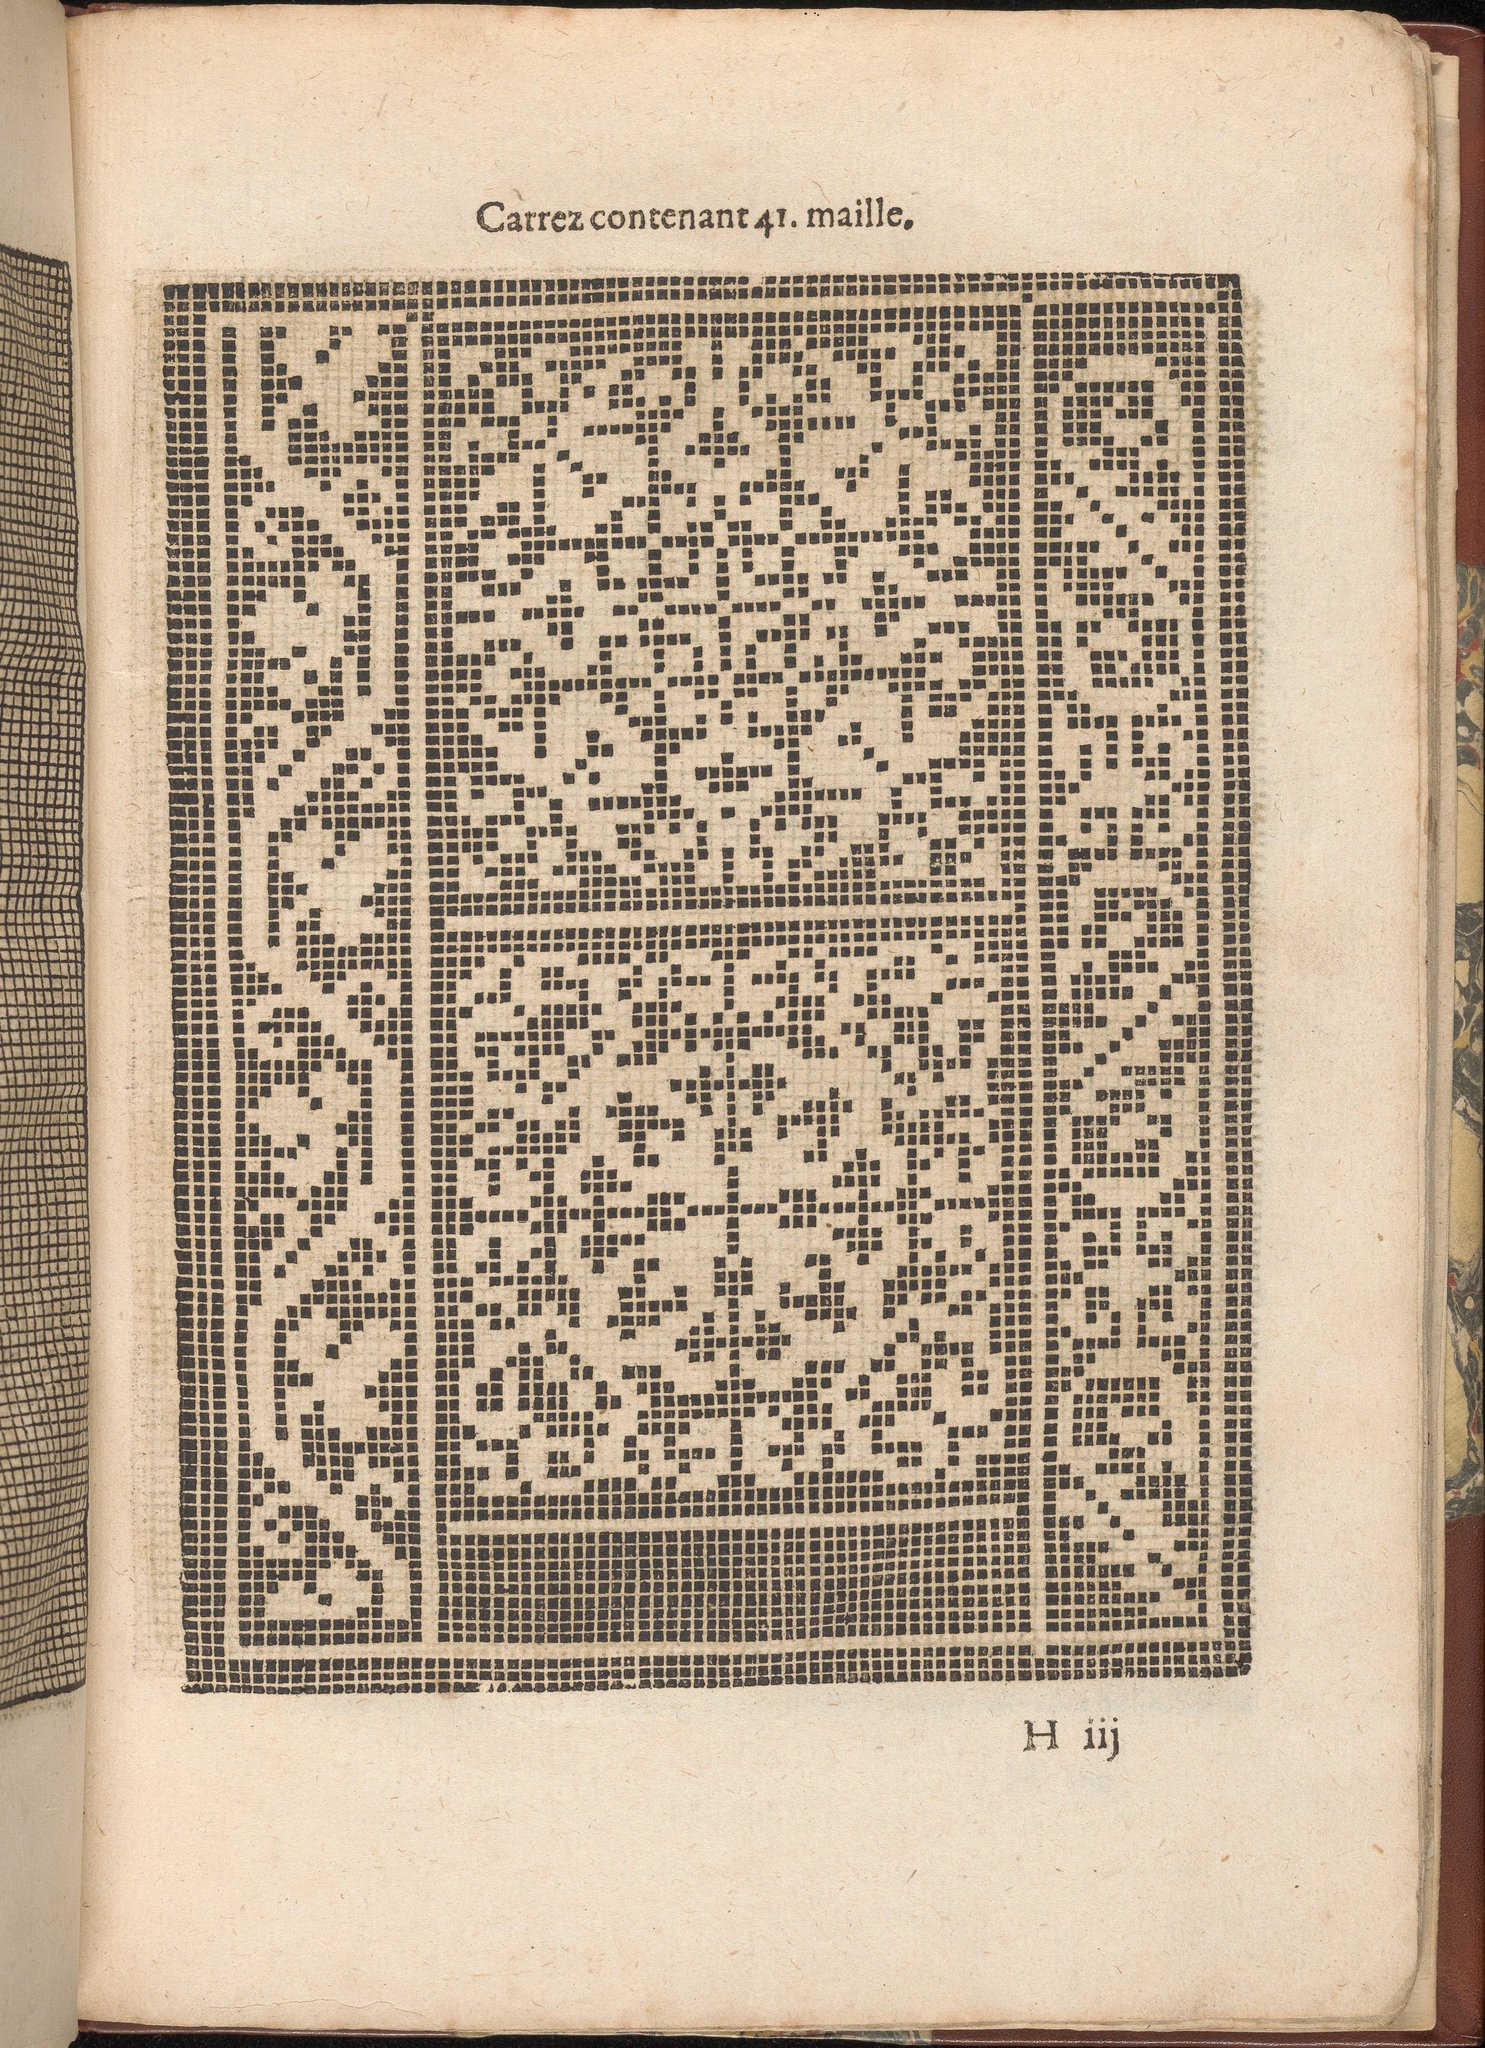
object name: book print ornament architecture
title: Les Secondes Oeuvres, et Subtiles Inventions De Lingerie du Seigneur Federic de Vinciolo Venitien, page 31 (recto)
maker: federico de vinciolo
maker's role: designer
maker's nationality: italian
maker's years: 1582-1599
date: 1603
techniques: woodcut